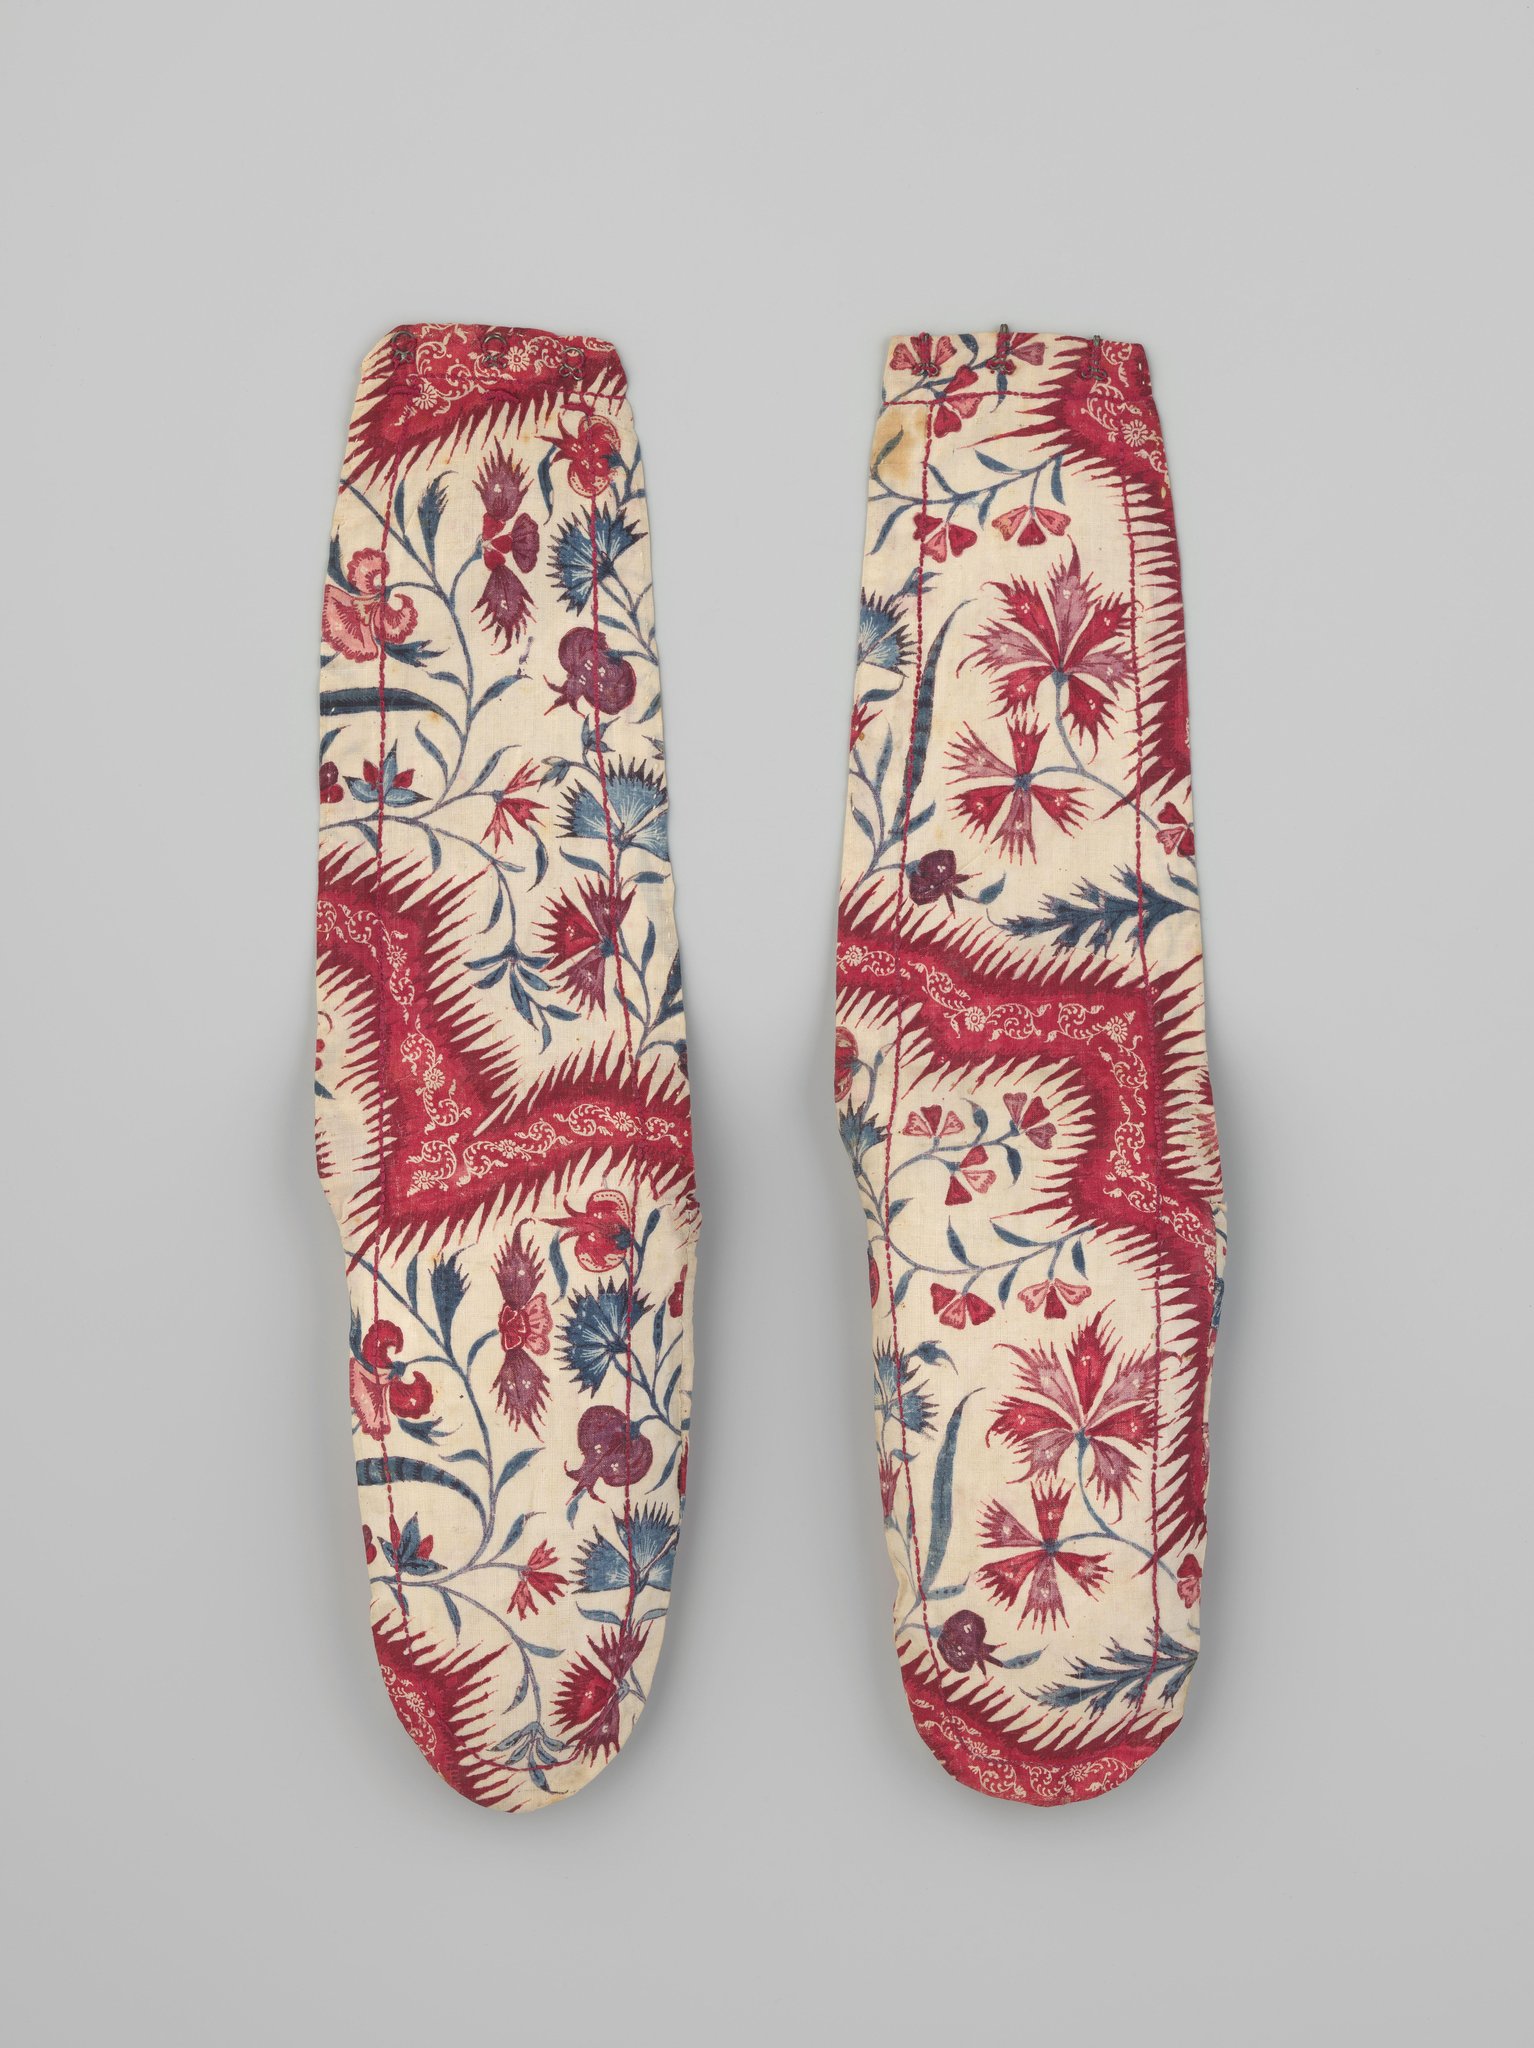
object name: childrenswear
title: A Pair of Oversleeves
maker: Anonymous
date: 1750-1775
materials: textile, cotton, linen, metal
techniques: sewing, stitching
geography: hindeloopen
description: Besides the carnations and other small flowers, this pattern consists of ‘flamed’ red scrollwork. Around 1985 the French firm of Braquenié revived this design, calling it Rivière enchantée. The sleeves, also named ‘bears’ claws’, were fastened at the wearer’s back. They covered the baby’s hands to prevent it from scratching itself.